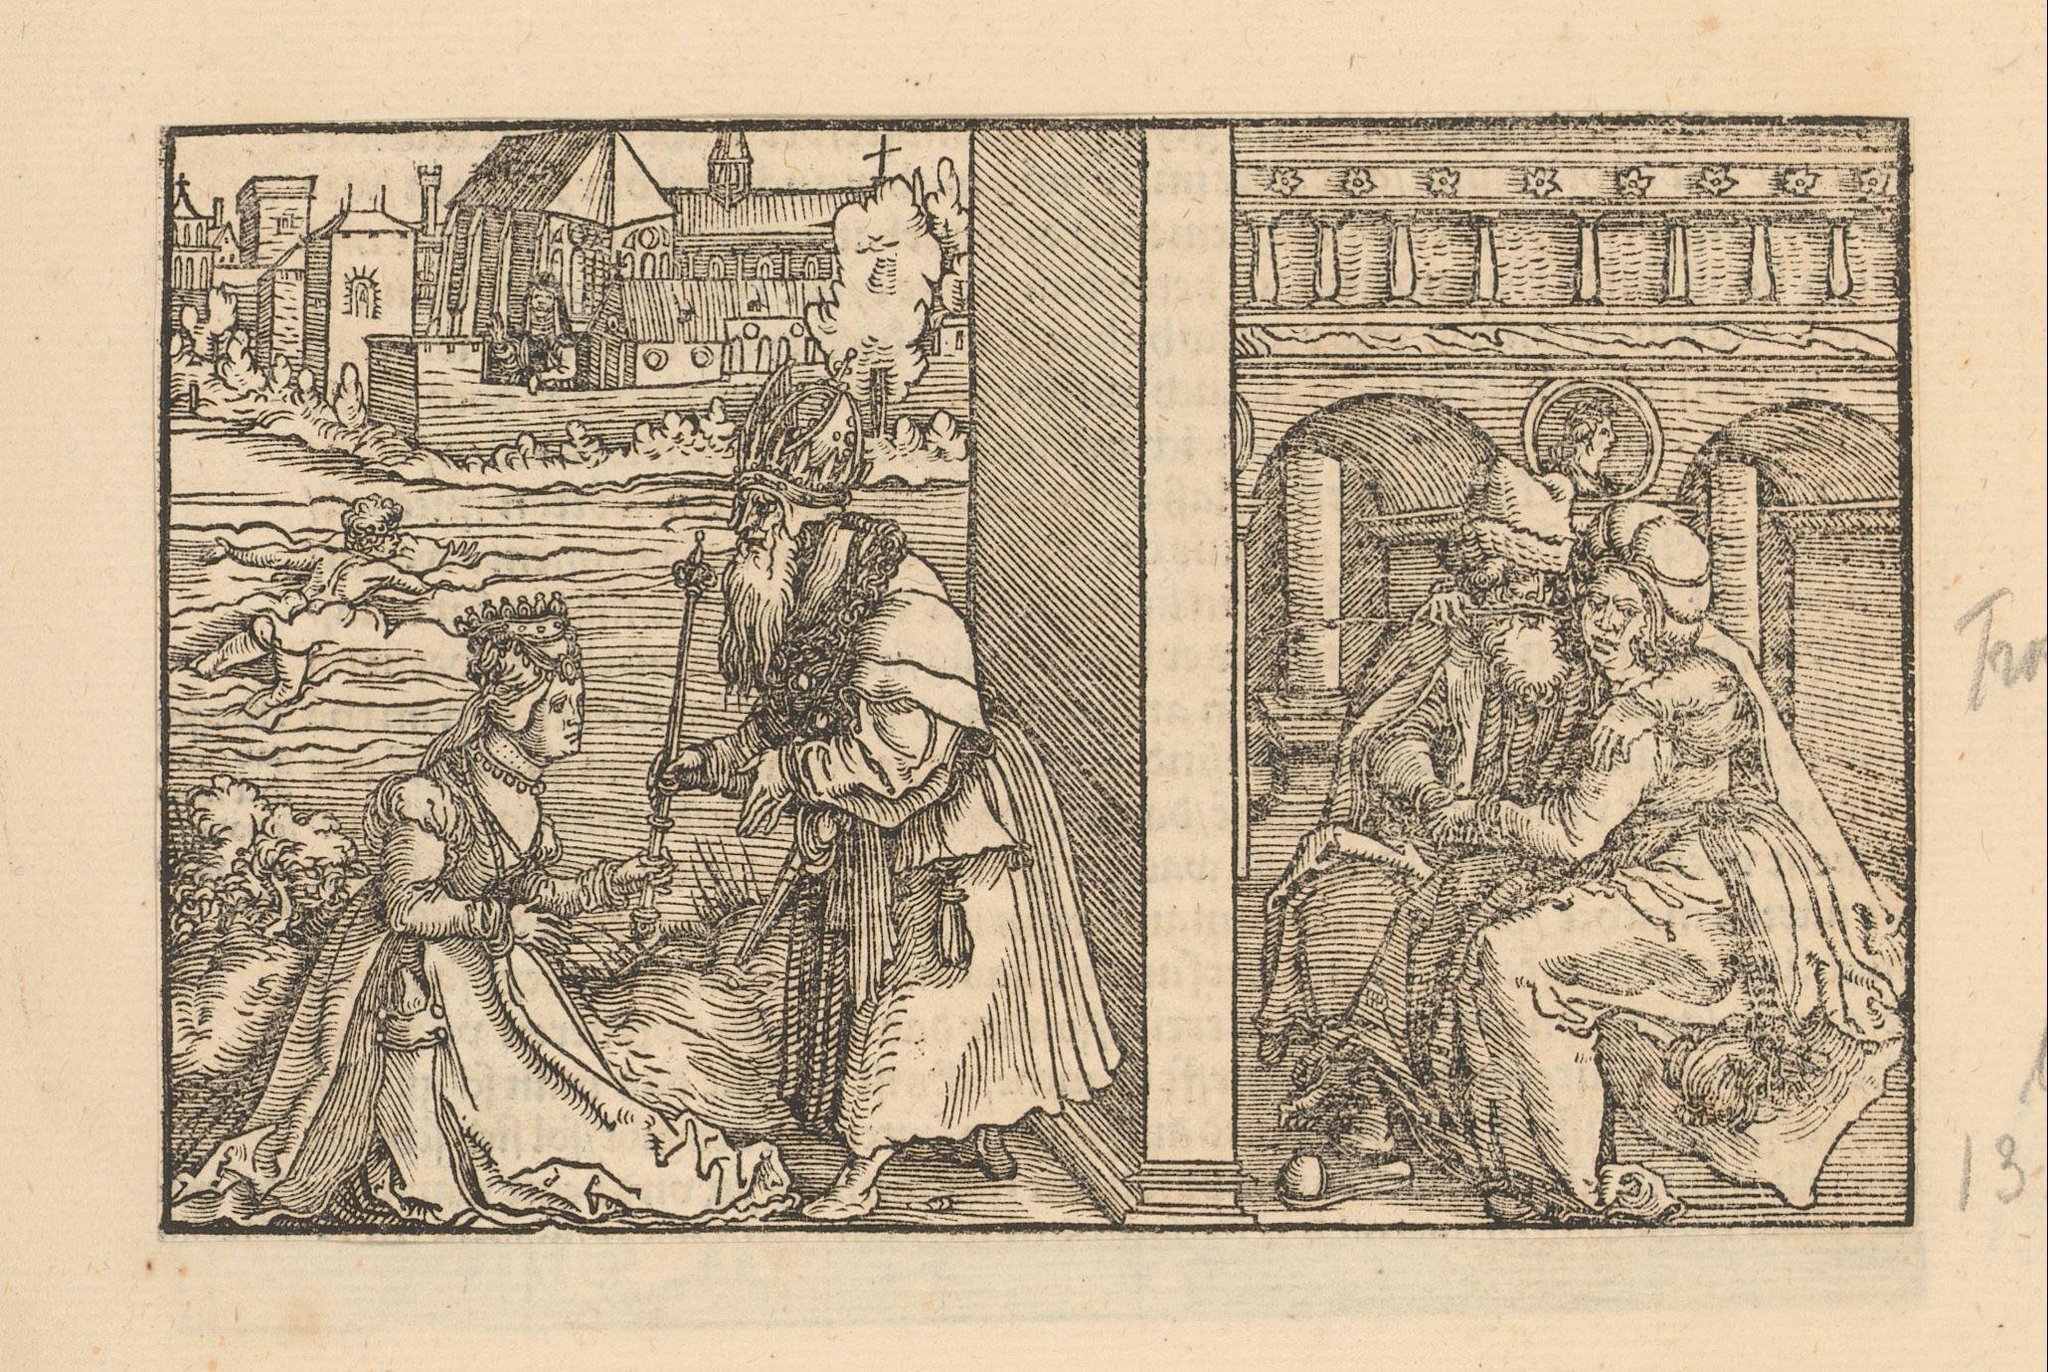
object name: print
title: Koninklijk paar en een liefdeskoppel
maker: Anonymous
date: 1514-1532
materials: paper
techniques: letterpress printing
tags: (lovers) embracing each other, 'symplegma', marriage, married couple, 'matrimonium', married couple of unequal wealth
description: Deze prent is gebruikt in: Petrarca, Francesco. Von der Artzney bayder Glück, des guten und widerwertigen: unnd weß sich ain yeder inn Gelück und Unglück halten sol (...). Augsburg: Heinrich Steiner, 1532. Deze uitgave is ook bekend onder de titel 'Trostspiegel in Glück und Unglück'.